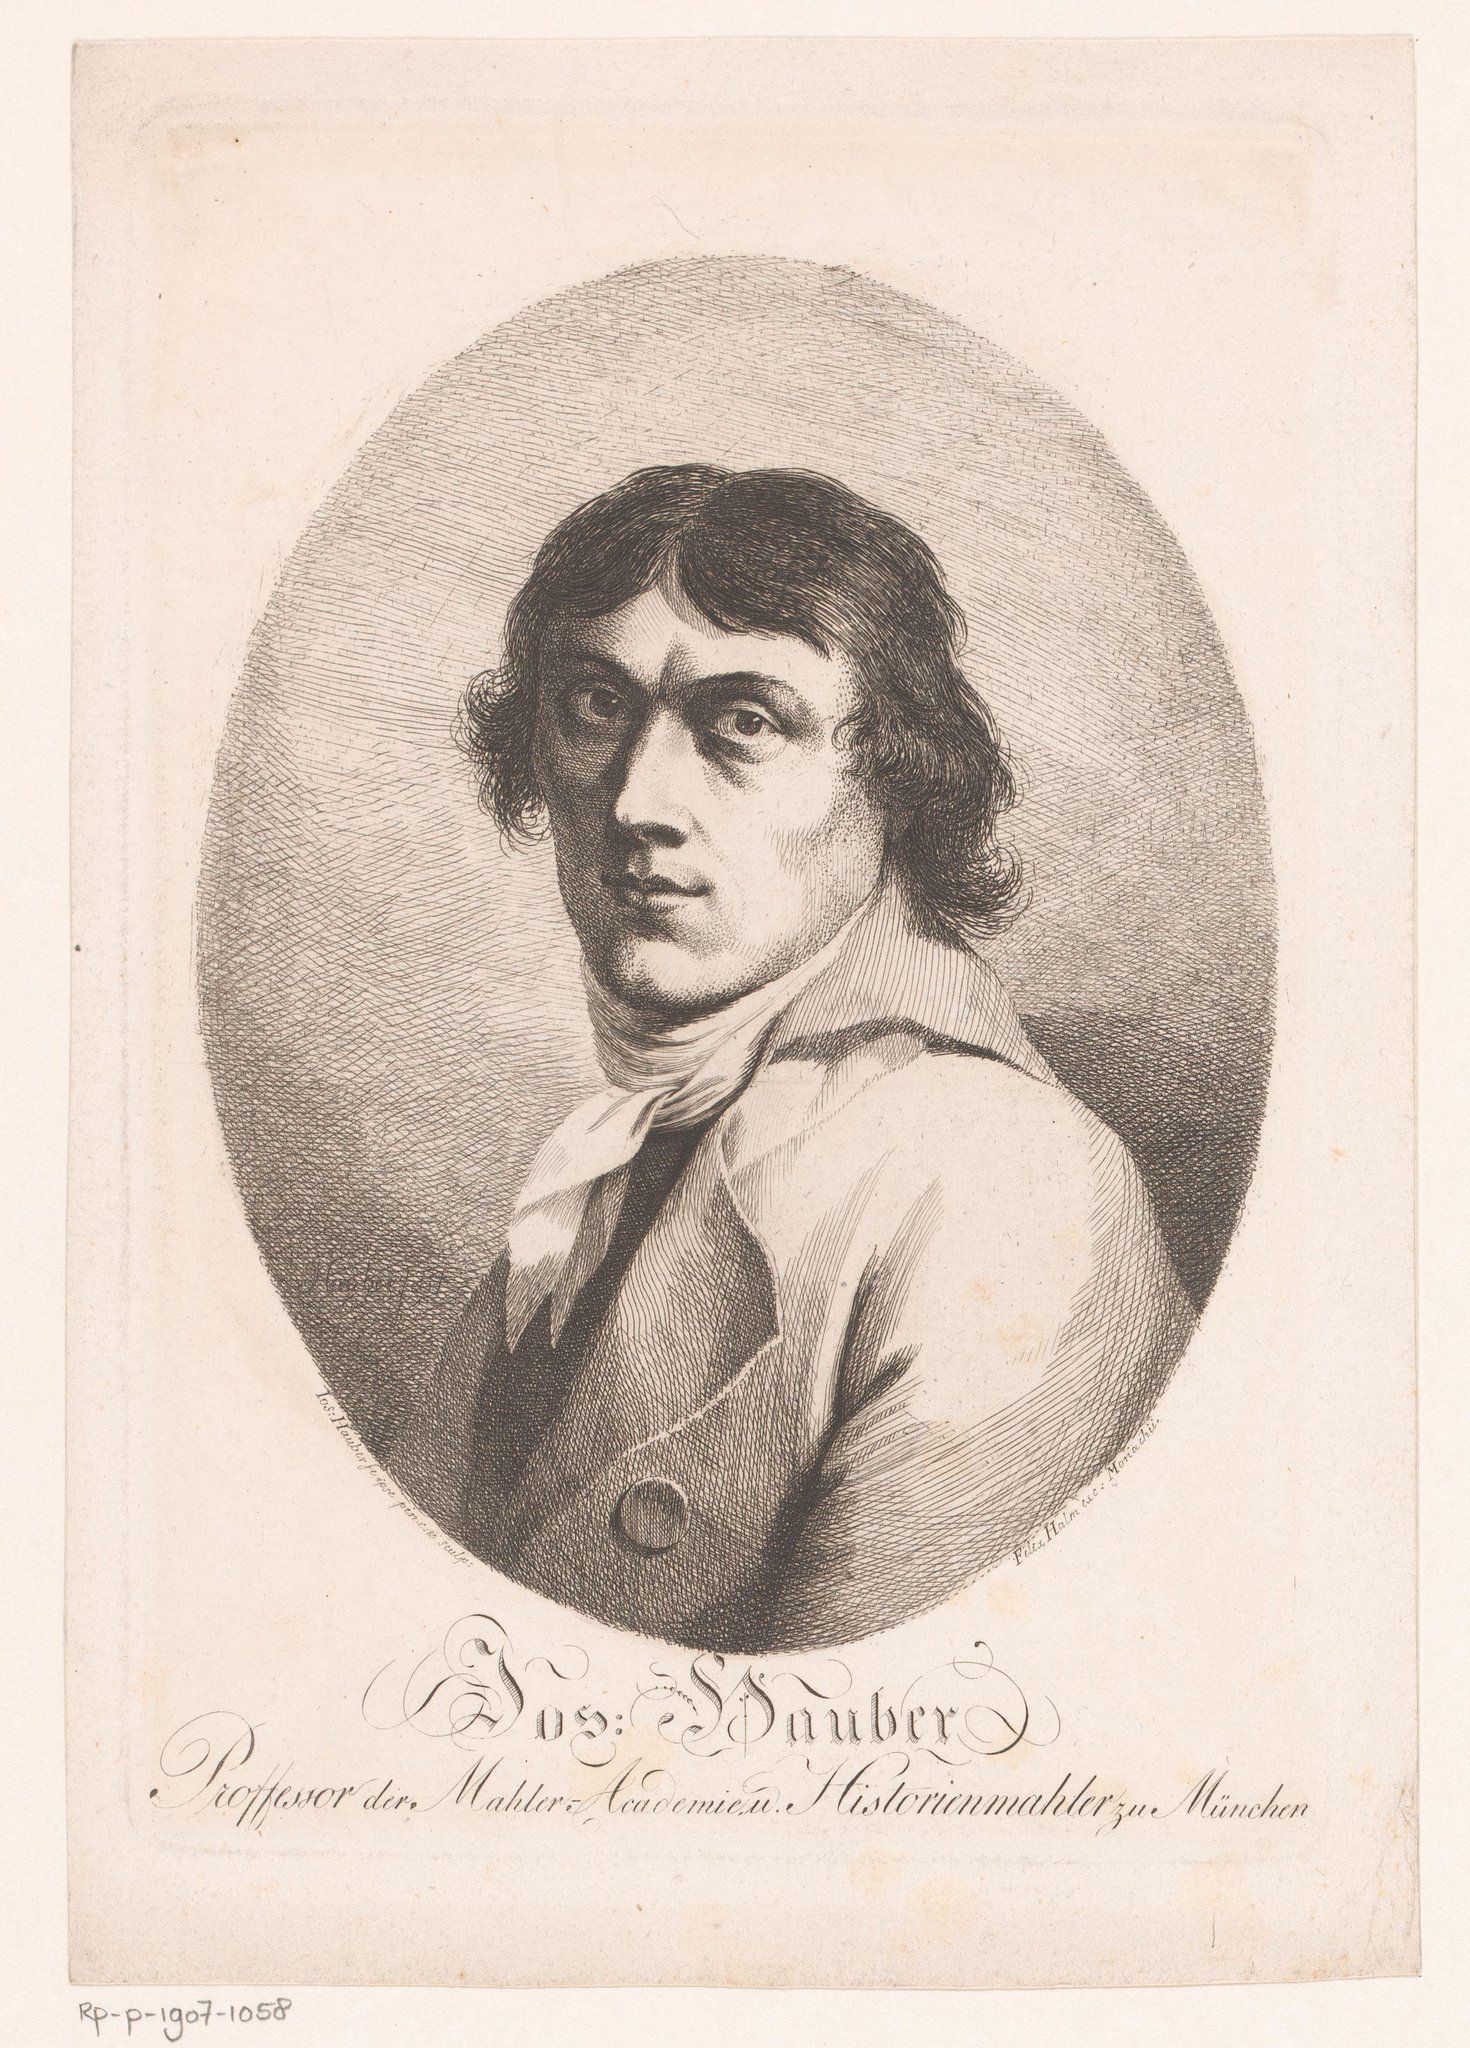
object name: print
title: Portret van Joseph Hauber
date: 1776-1810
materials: paper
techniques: etching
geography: munich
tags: print maker, joseph hauber, portrait, self-portrait of painter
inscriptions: collector's mark: Lugt 2228